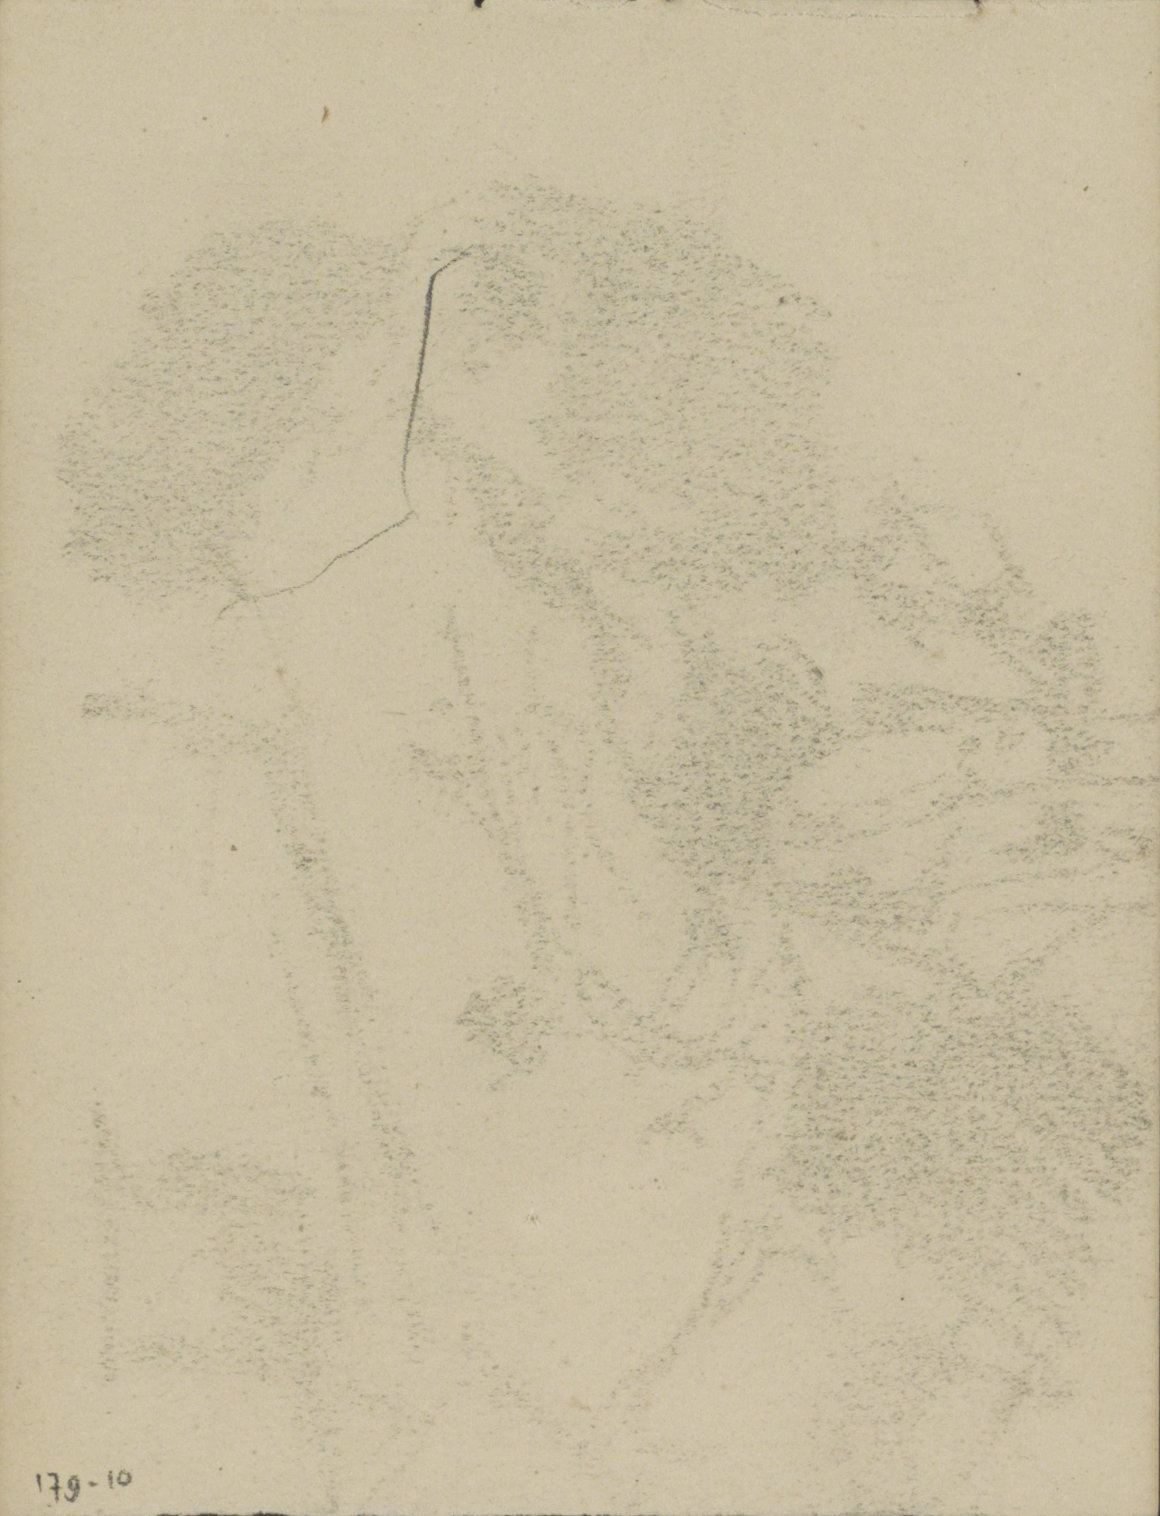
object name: drawing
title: Abklatsch van een tekening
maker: george hendrik breitner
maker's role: draughtsman, painter, print maker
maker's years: 1857-1923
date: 1873-1923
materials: paper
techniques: printmaking